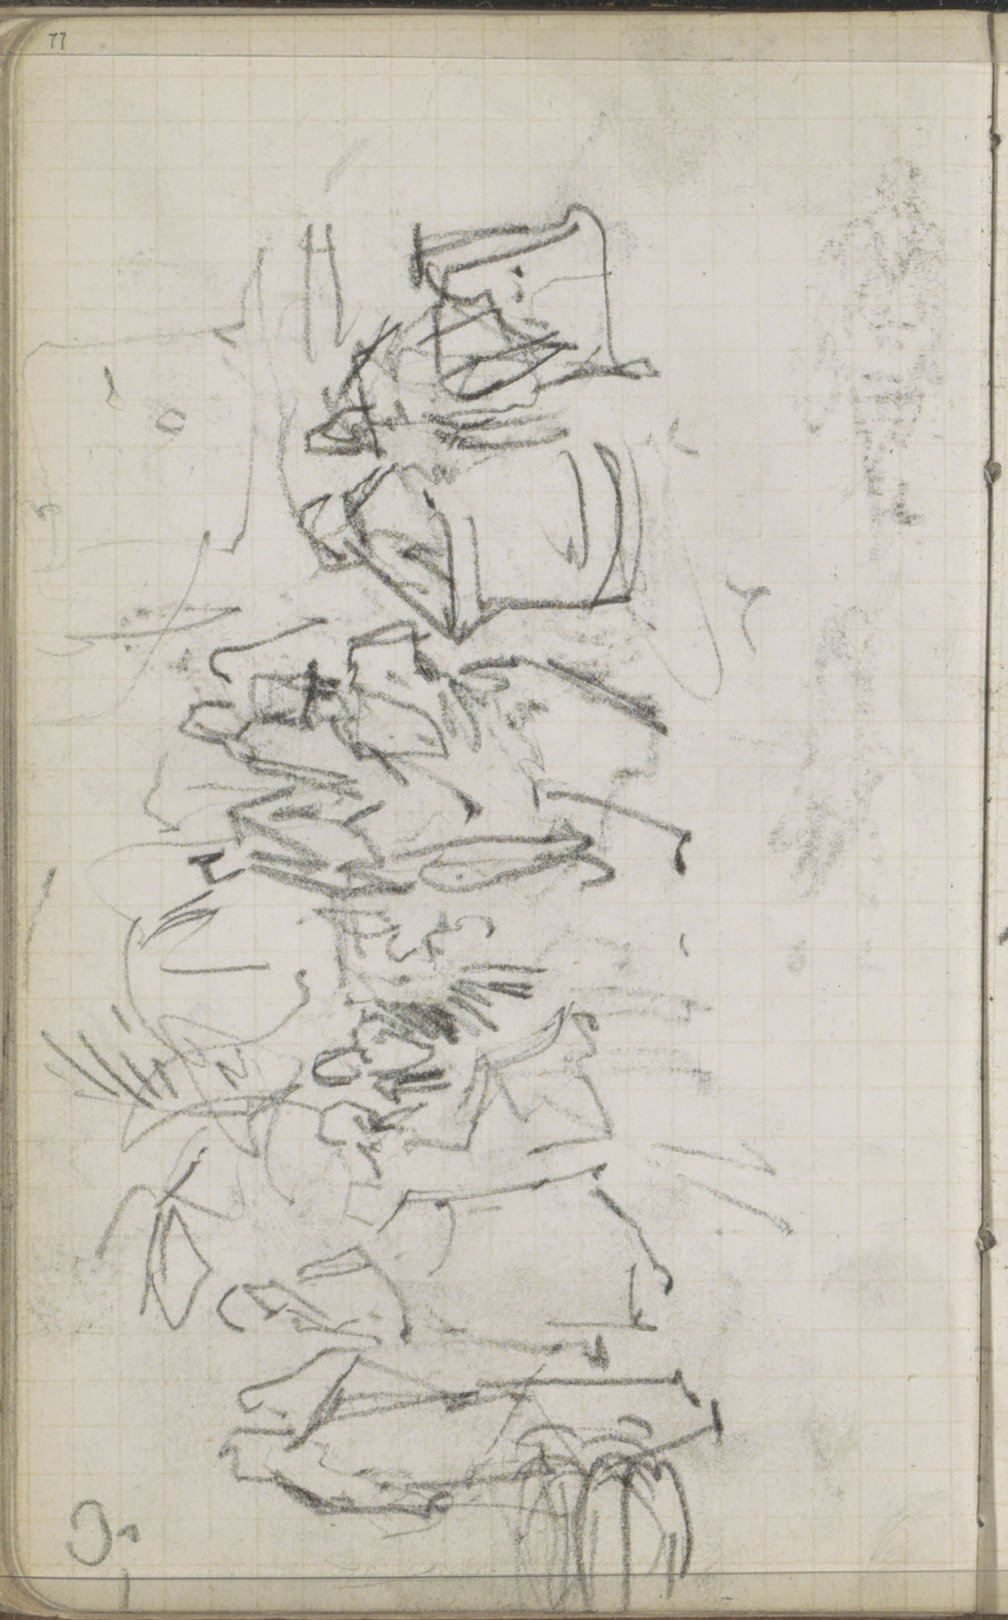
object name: sketchbook leaf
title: Groep figuren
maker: marius bauer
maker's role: draughtsman, print maker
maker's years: 1867-1932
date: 1879-1885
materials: chalk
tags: standing figure, sitting figure, adult woman, adult man, inn, coffee-house, public house, etc.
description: Mogelijk bevinden de figuren zich in een café of restaurant. Pagina 77 uit een schetsboek met 58 bladen.